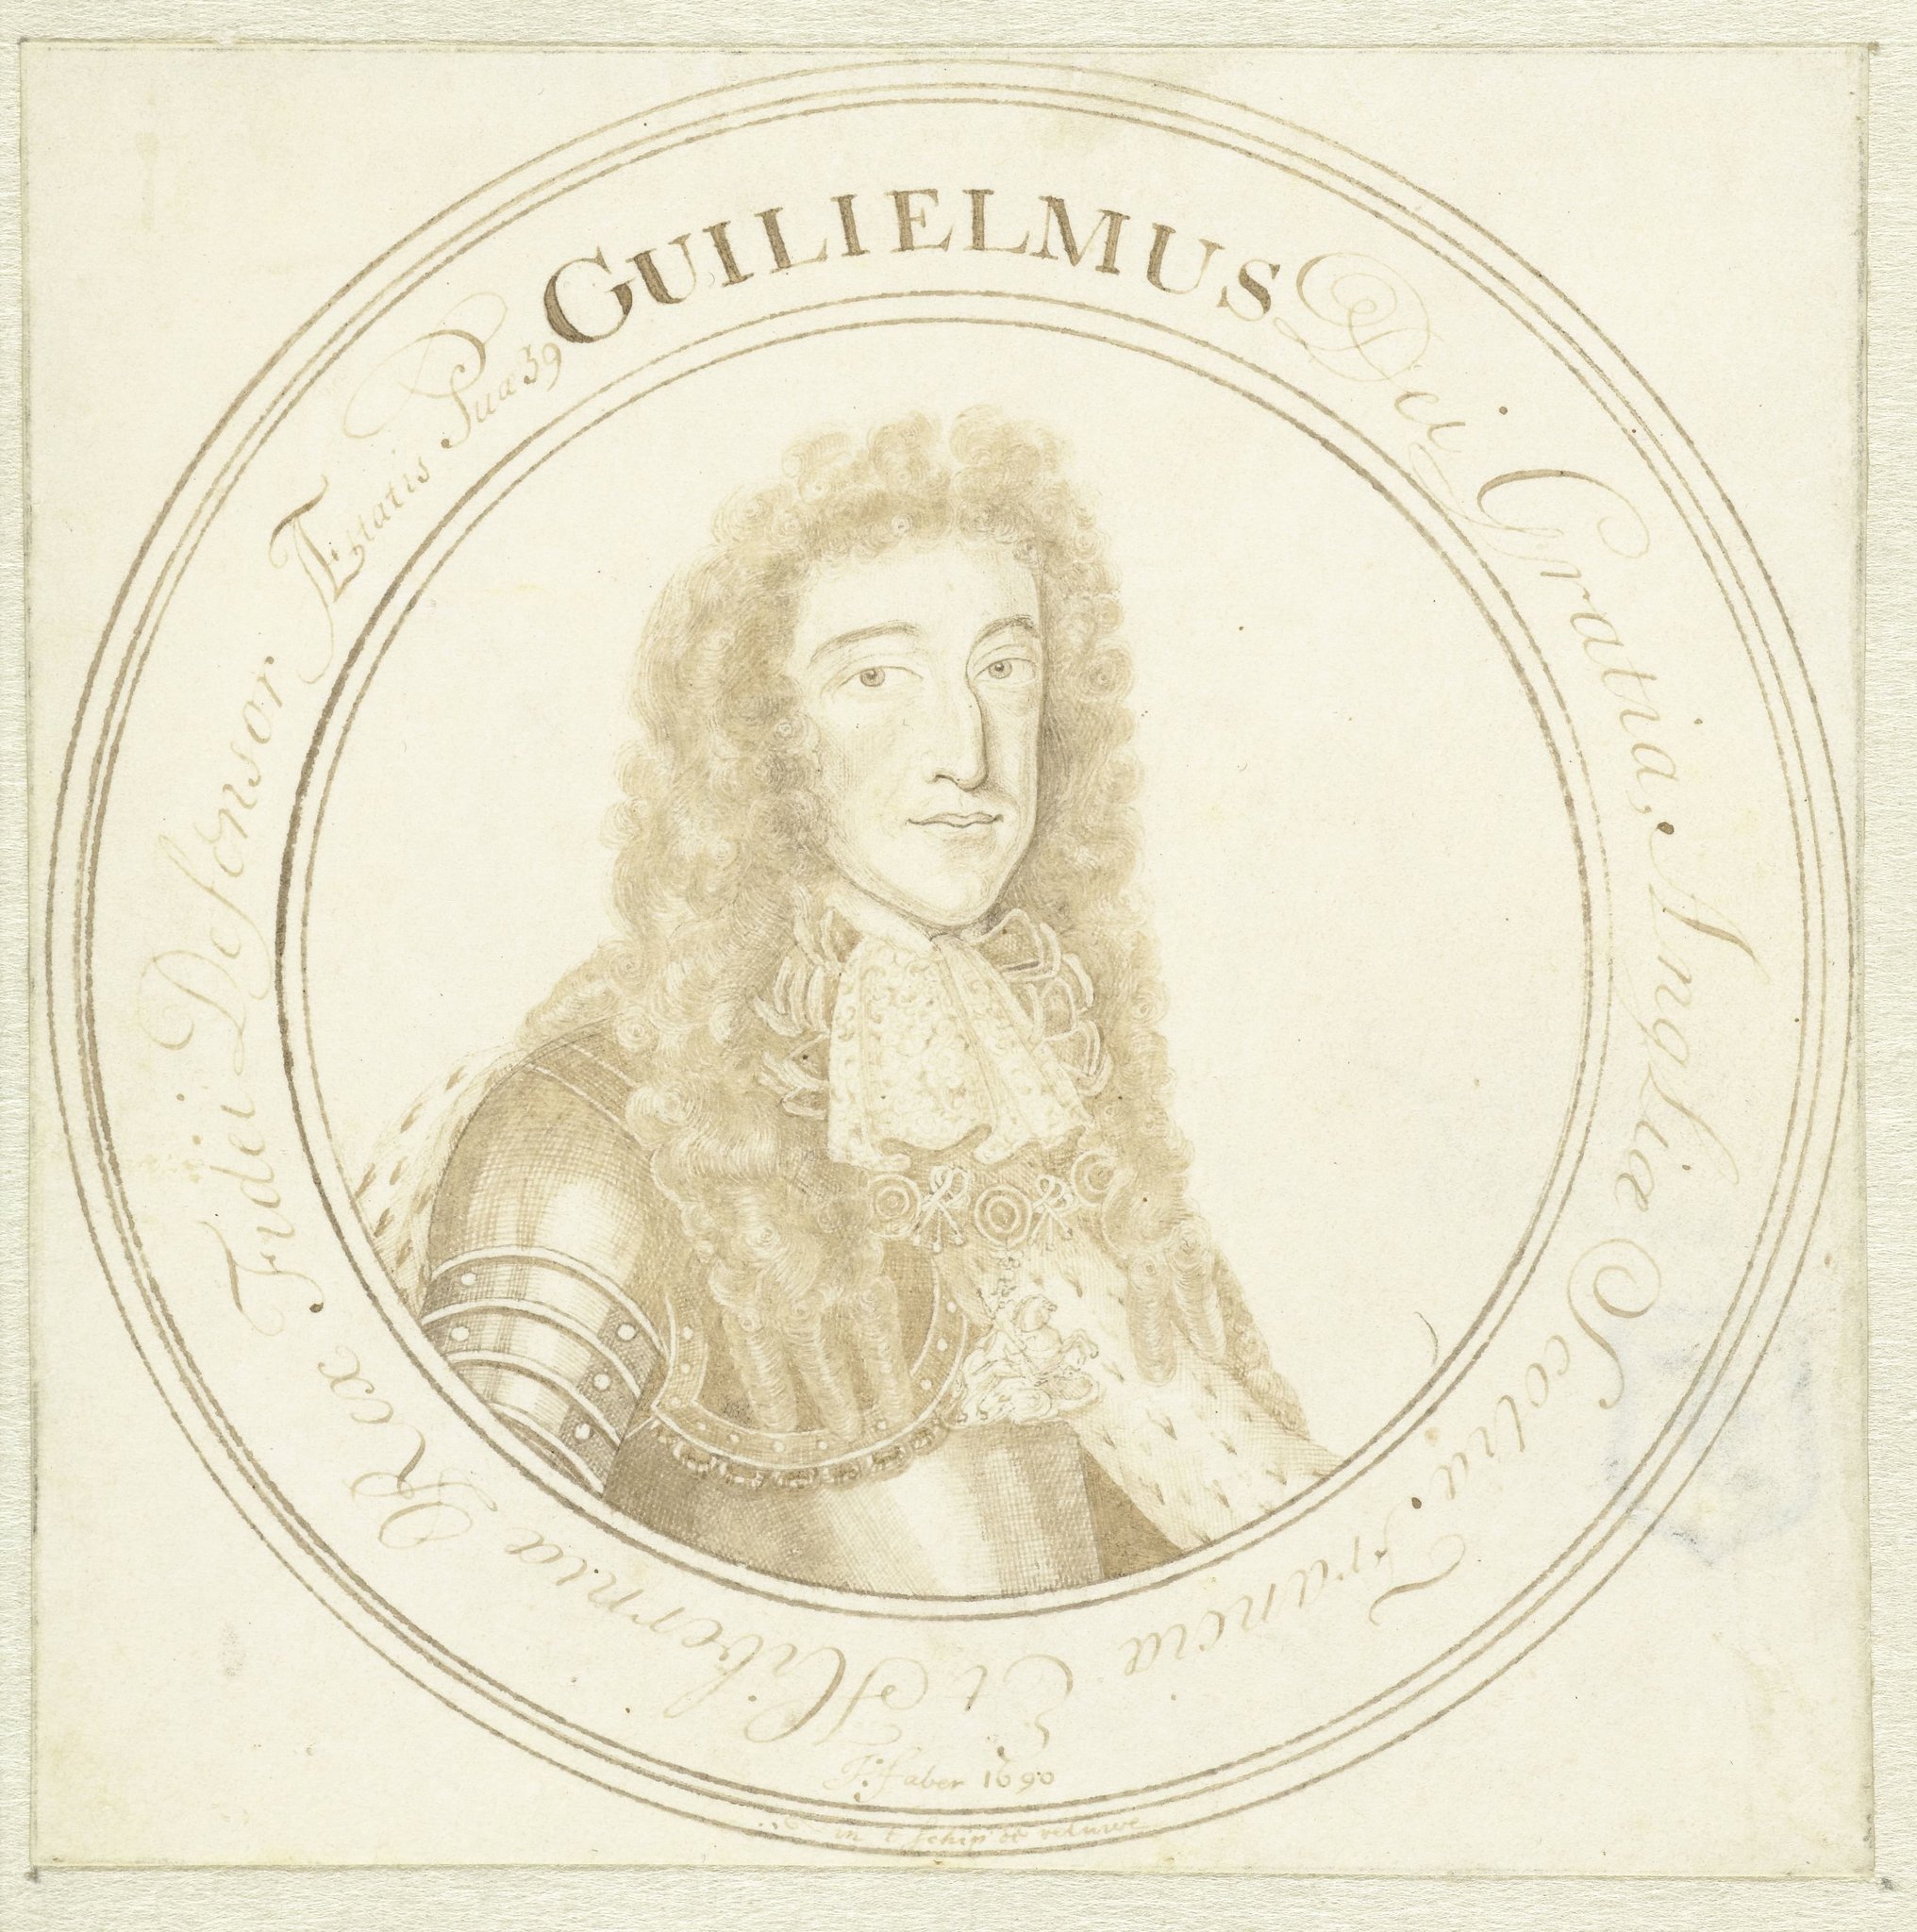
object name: drawing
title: Portret van Prins Willem III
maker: john faber (i)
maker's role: draughtsman, print maker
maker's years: 1650-1721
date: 1690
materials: ink, parchment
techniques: pen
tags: william iii (prince of orange and king of england, scotland, and ireland)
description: Pendant van "Portret van Maria Stuart" (inv.nr. RP-T-1898-A-3957).